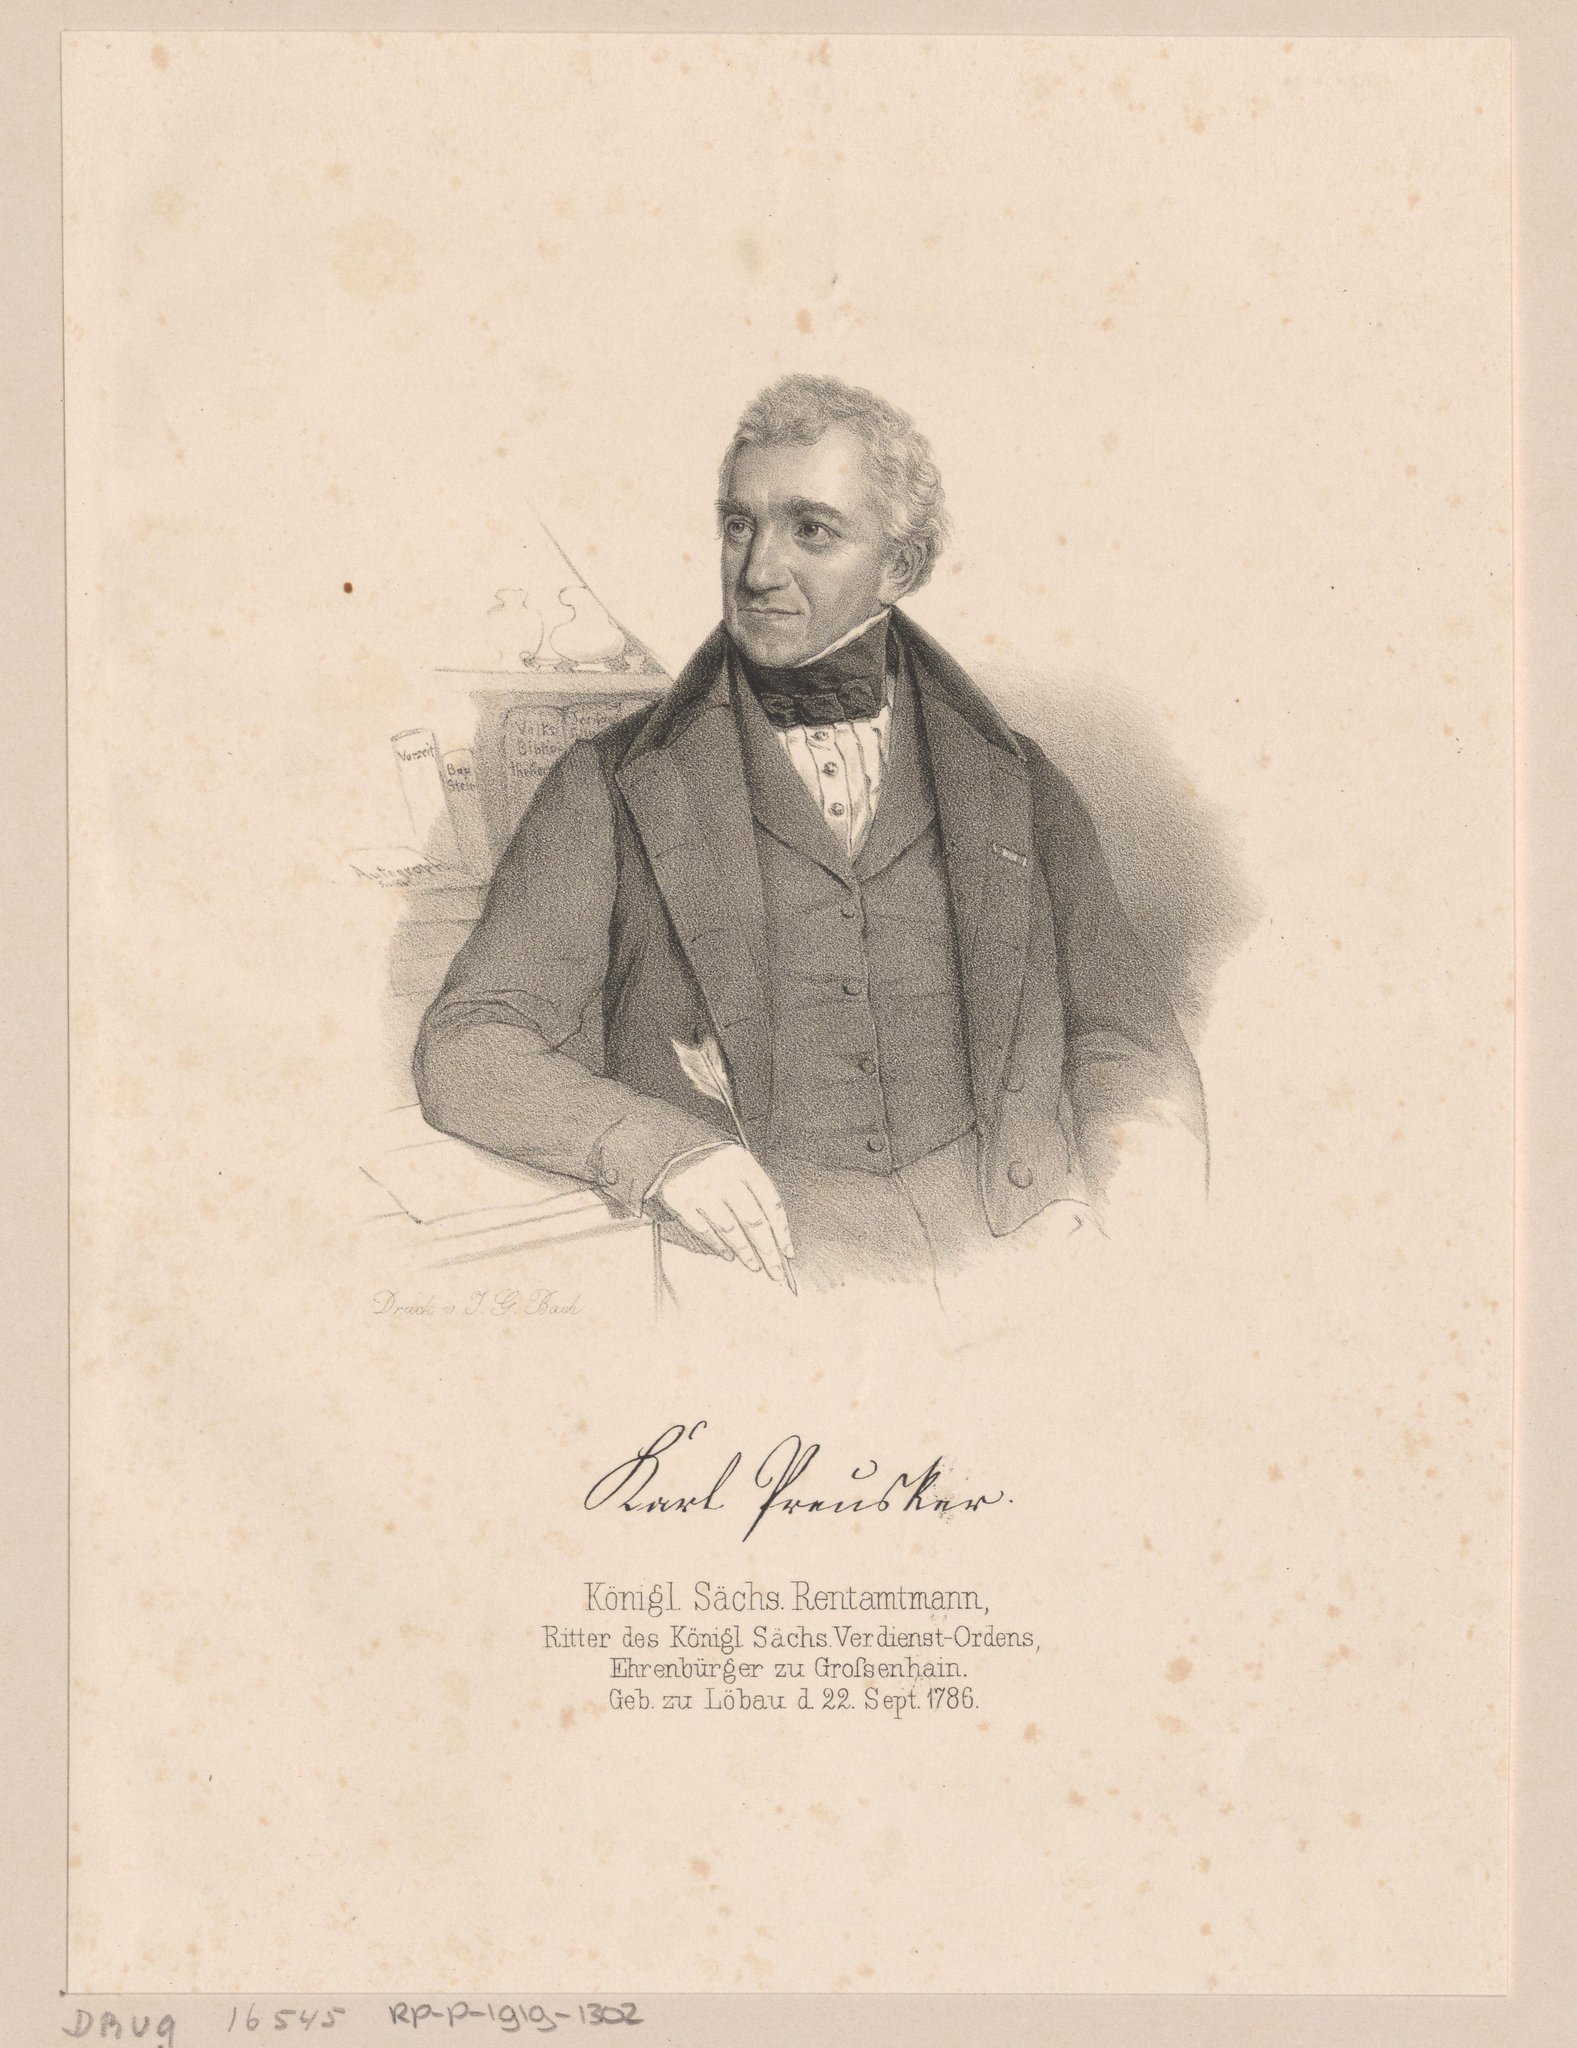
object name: print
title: Portret van Karl Preusker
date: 1840-1860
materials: paper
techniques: lithograph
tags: knighthood order, historical persons, portrait of a writer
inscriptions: collector's mark: Lugt 2228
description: Met vierregelig onderschrift in het Duits.